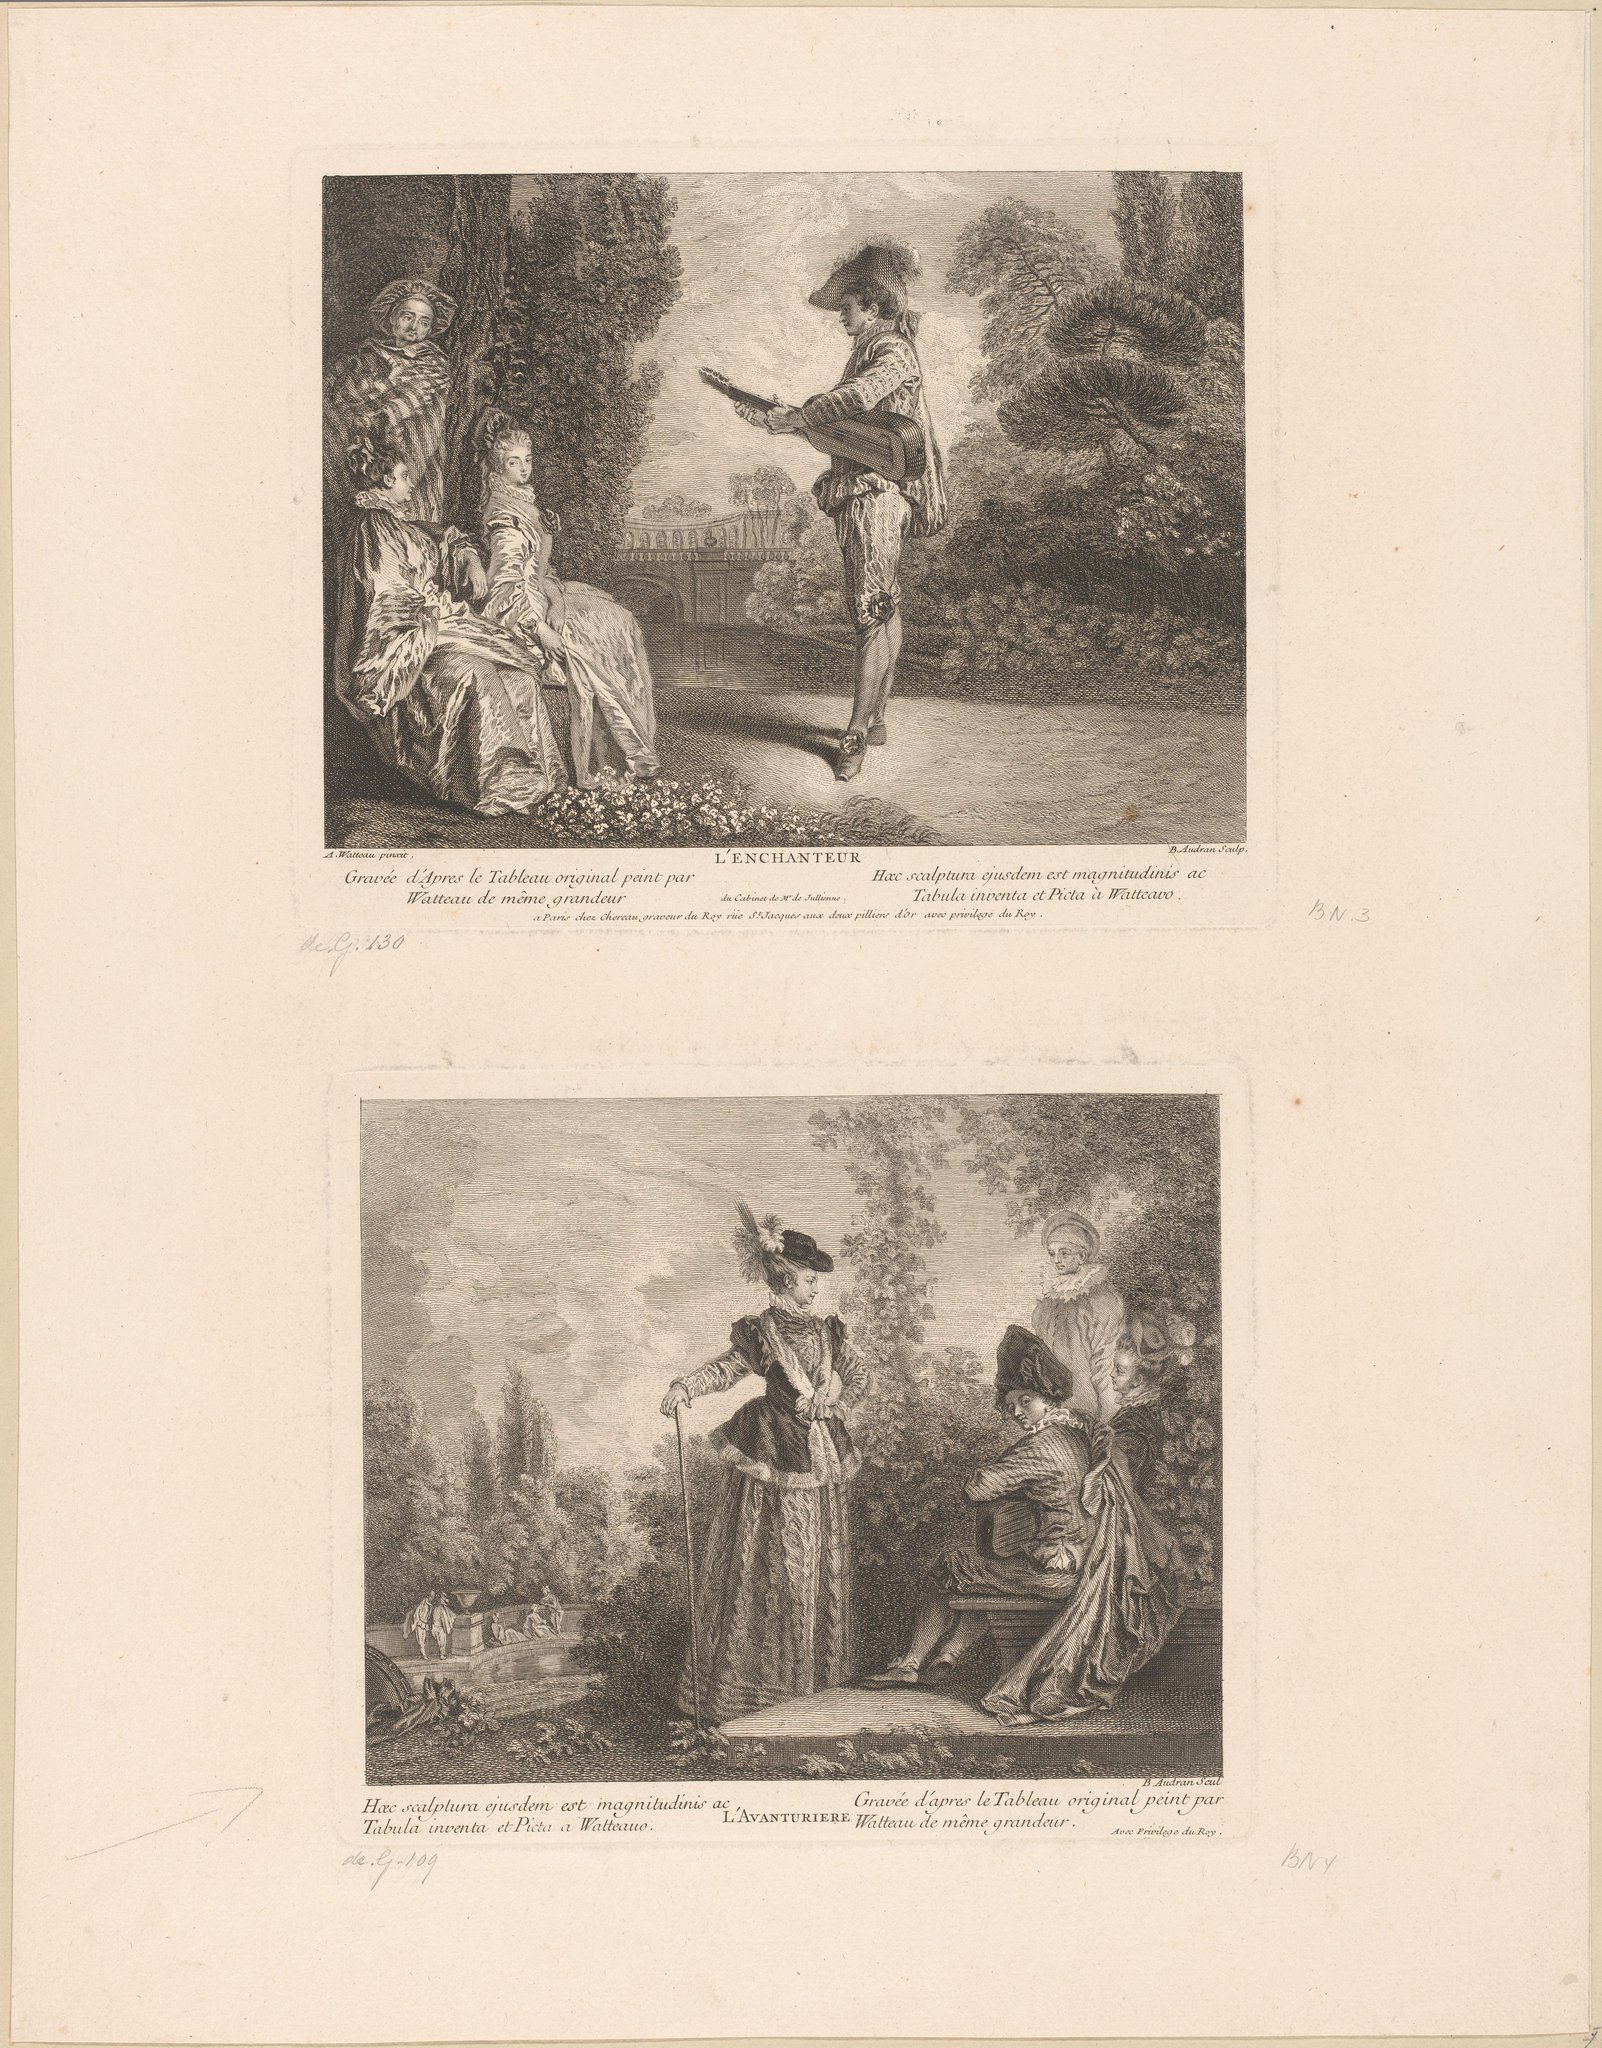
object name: print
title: L'enchanteur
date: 1708-1729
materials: paper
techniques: etching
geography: paris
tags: types in 'commedia dell'arte': pierrot, adventurer, making music; musician with instrument - cc - out of doors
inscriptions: collector's mark: Lugt 2228, collector's mark: Lugt 2228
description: De bovenste plaat verbeeldt een man met hoed die voor twee gezeten vrouwen en een staande Pierrotfiguur op zijn snaarinstrument speelt. Op de onderste plaat bevindt zich centraal een vrouw in akimbo houding met wandelstok en rechts een gezeten koppel en een staande Pierrotfiguur. Beide taferelen spelen zich in de openlucht af.